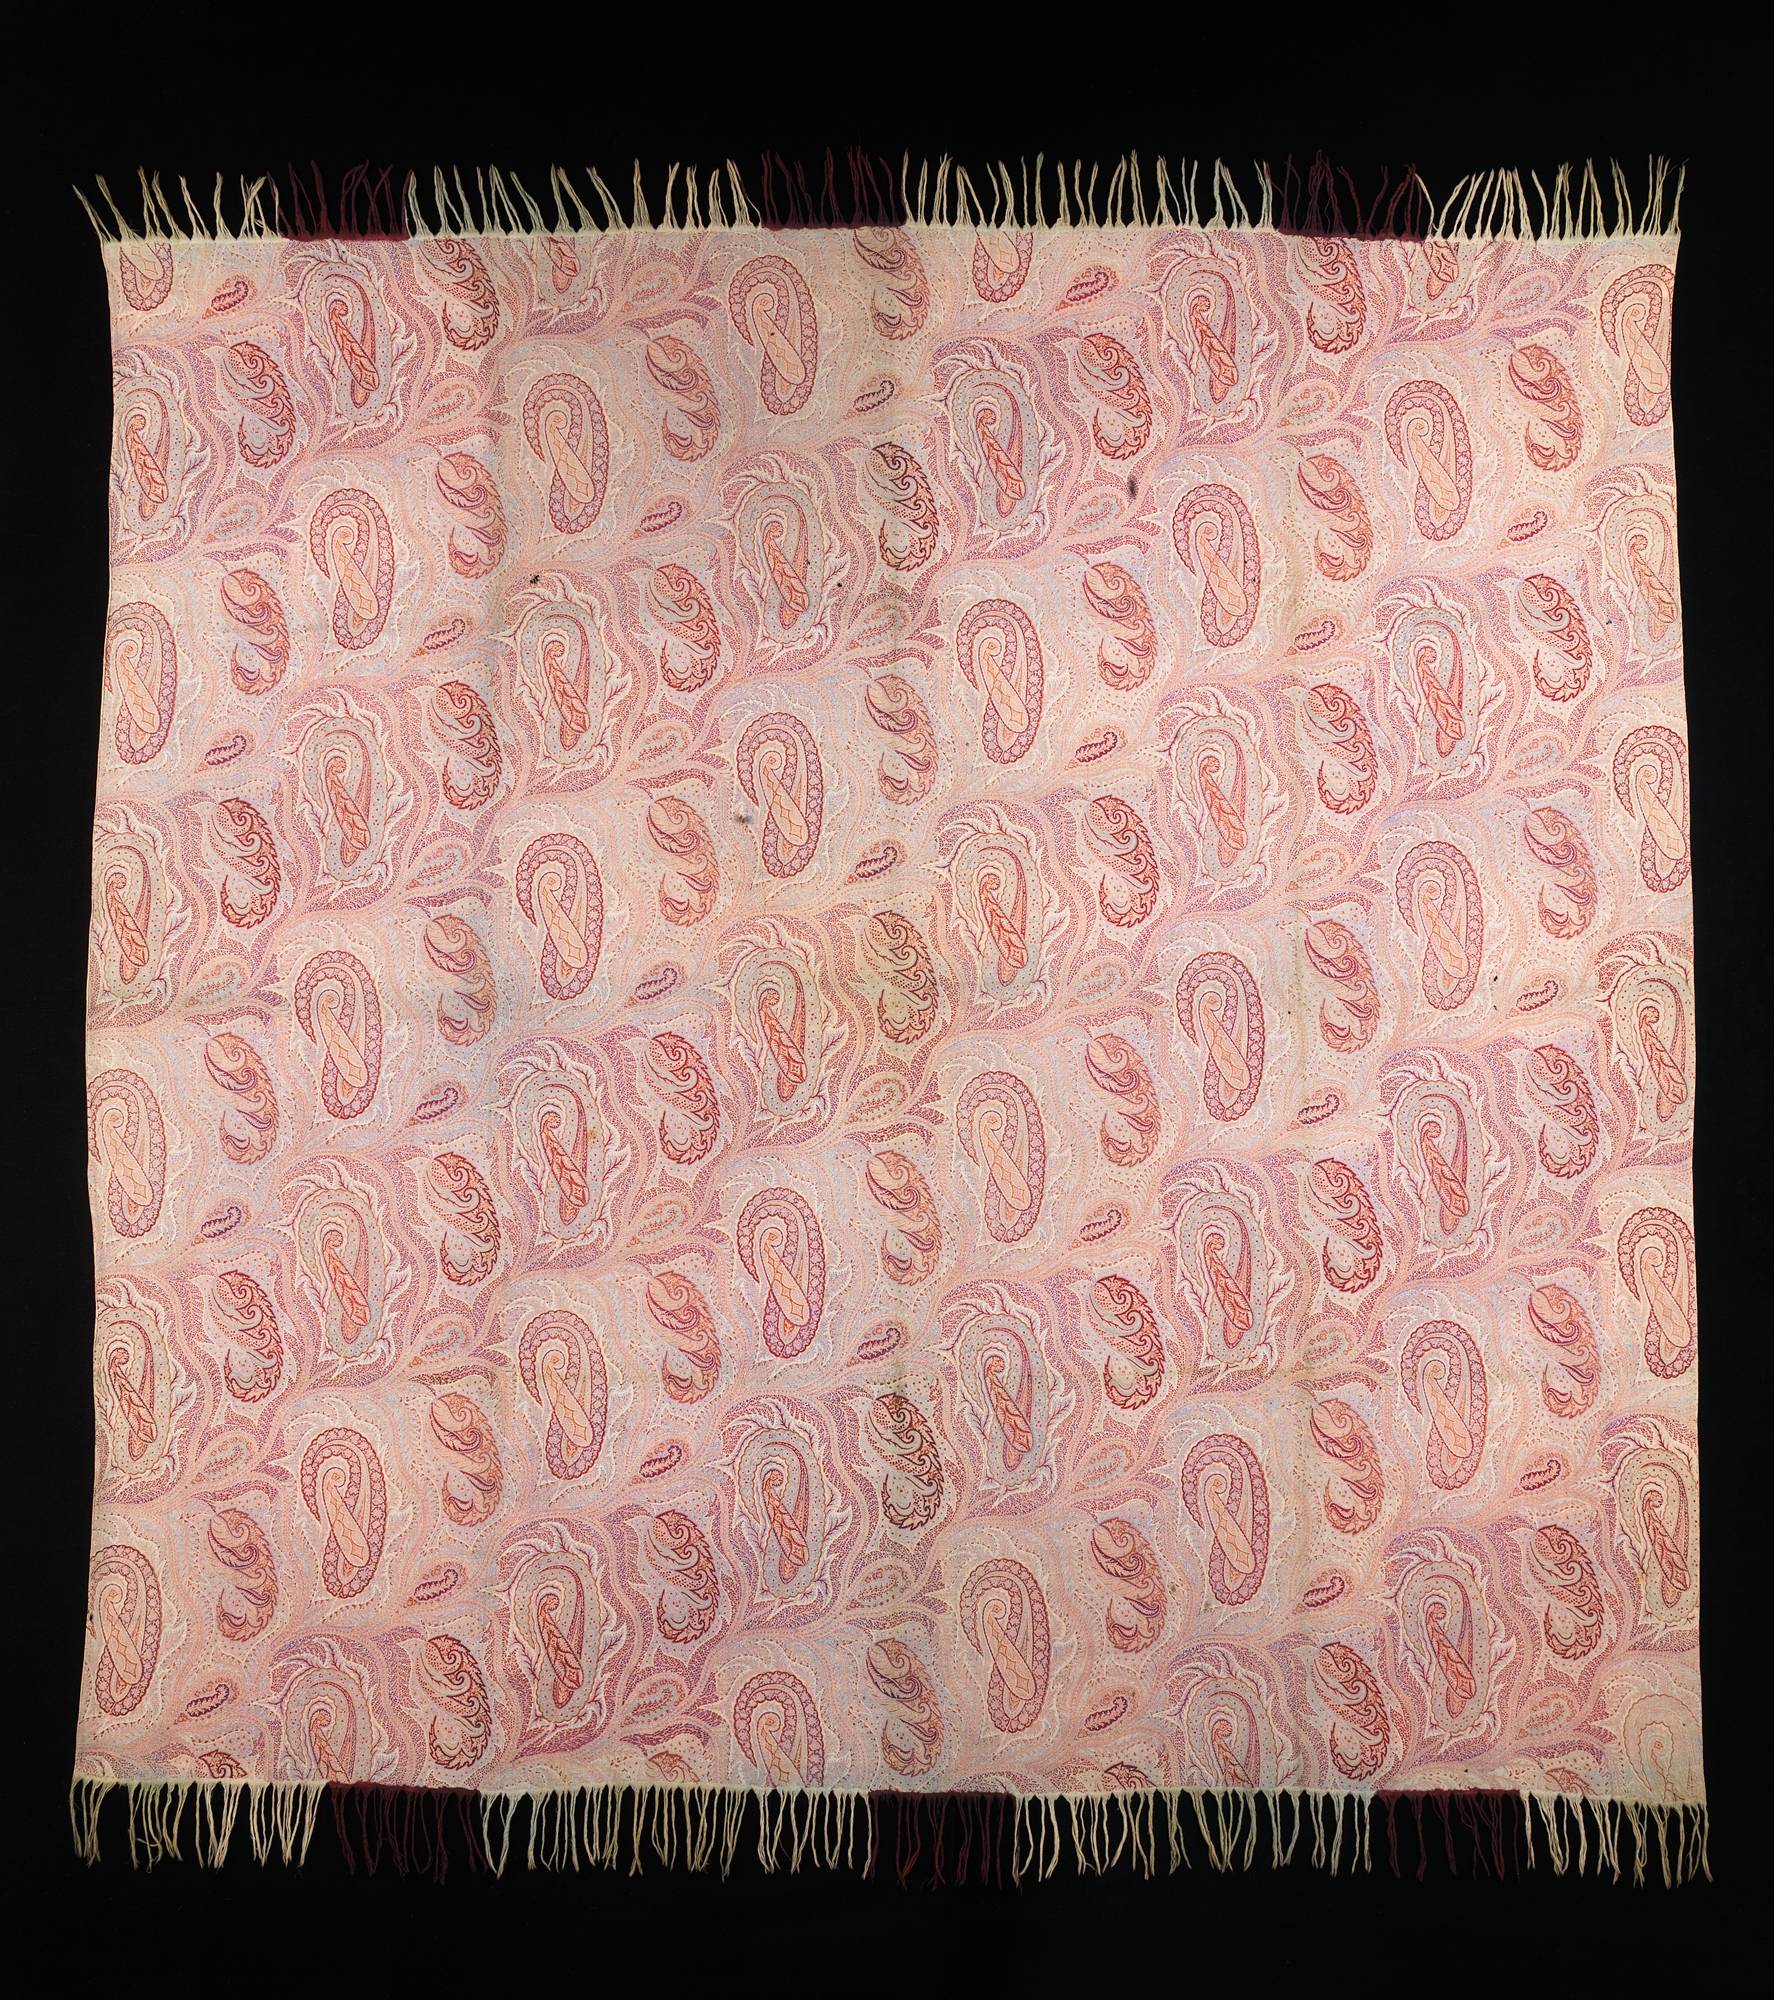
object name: shawl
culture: british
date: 1850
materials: wool